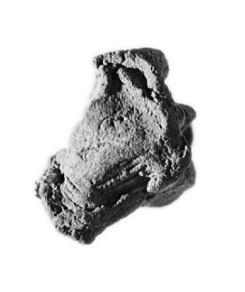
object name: sealing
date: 1981-1640 BCE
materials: mud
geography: egypt